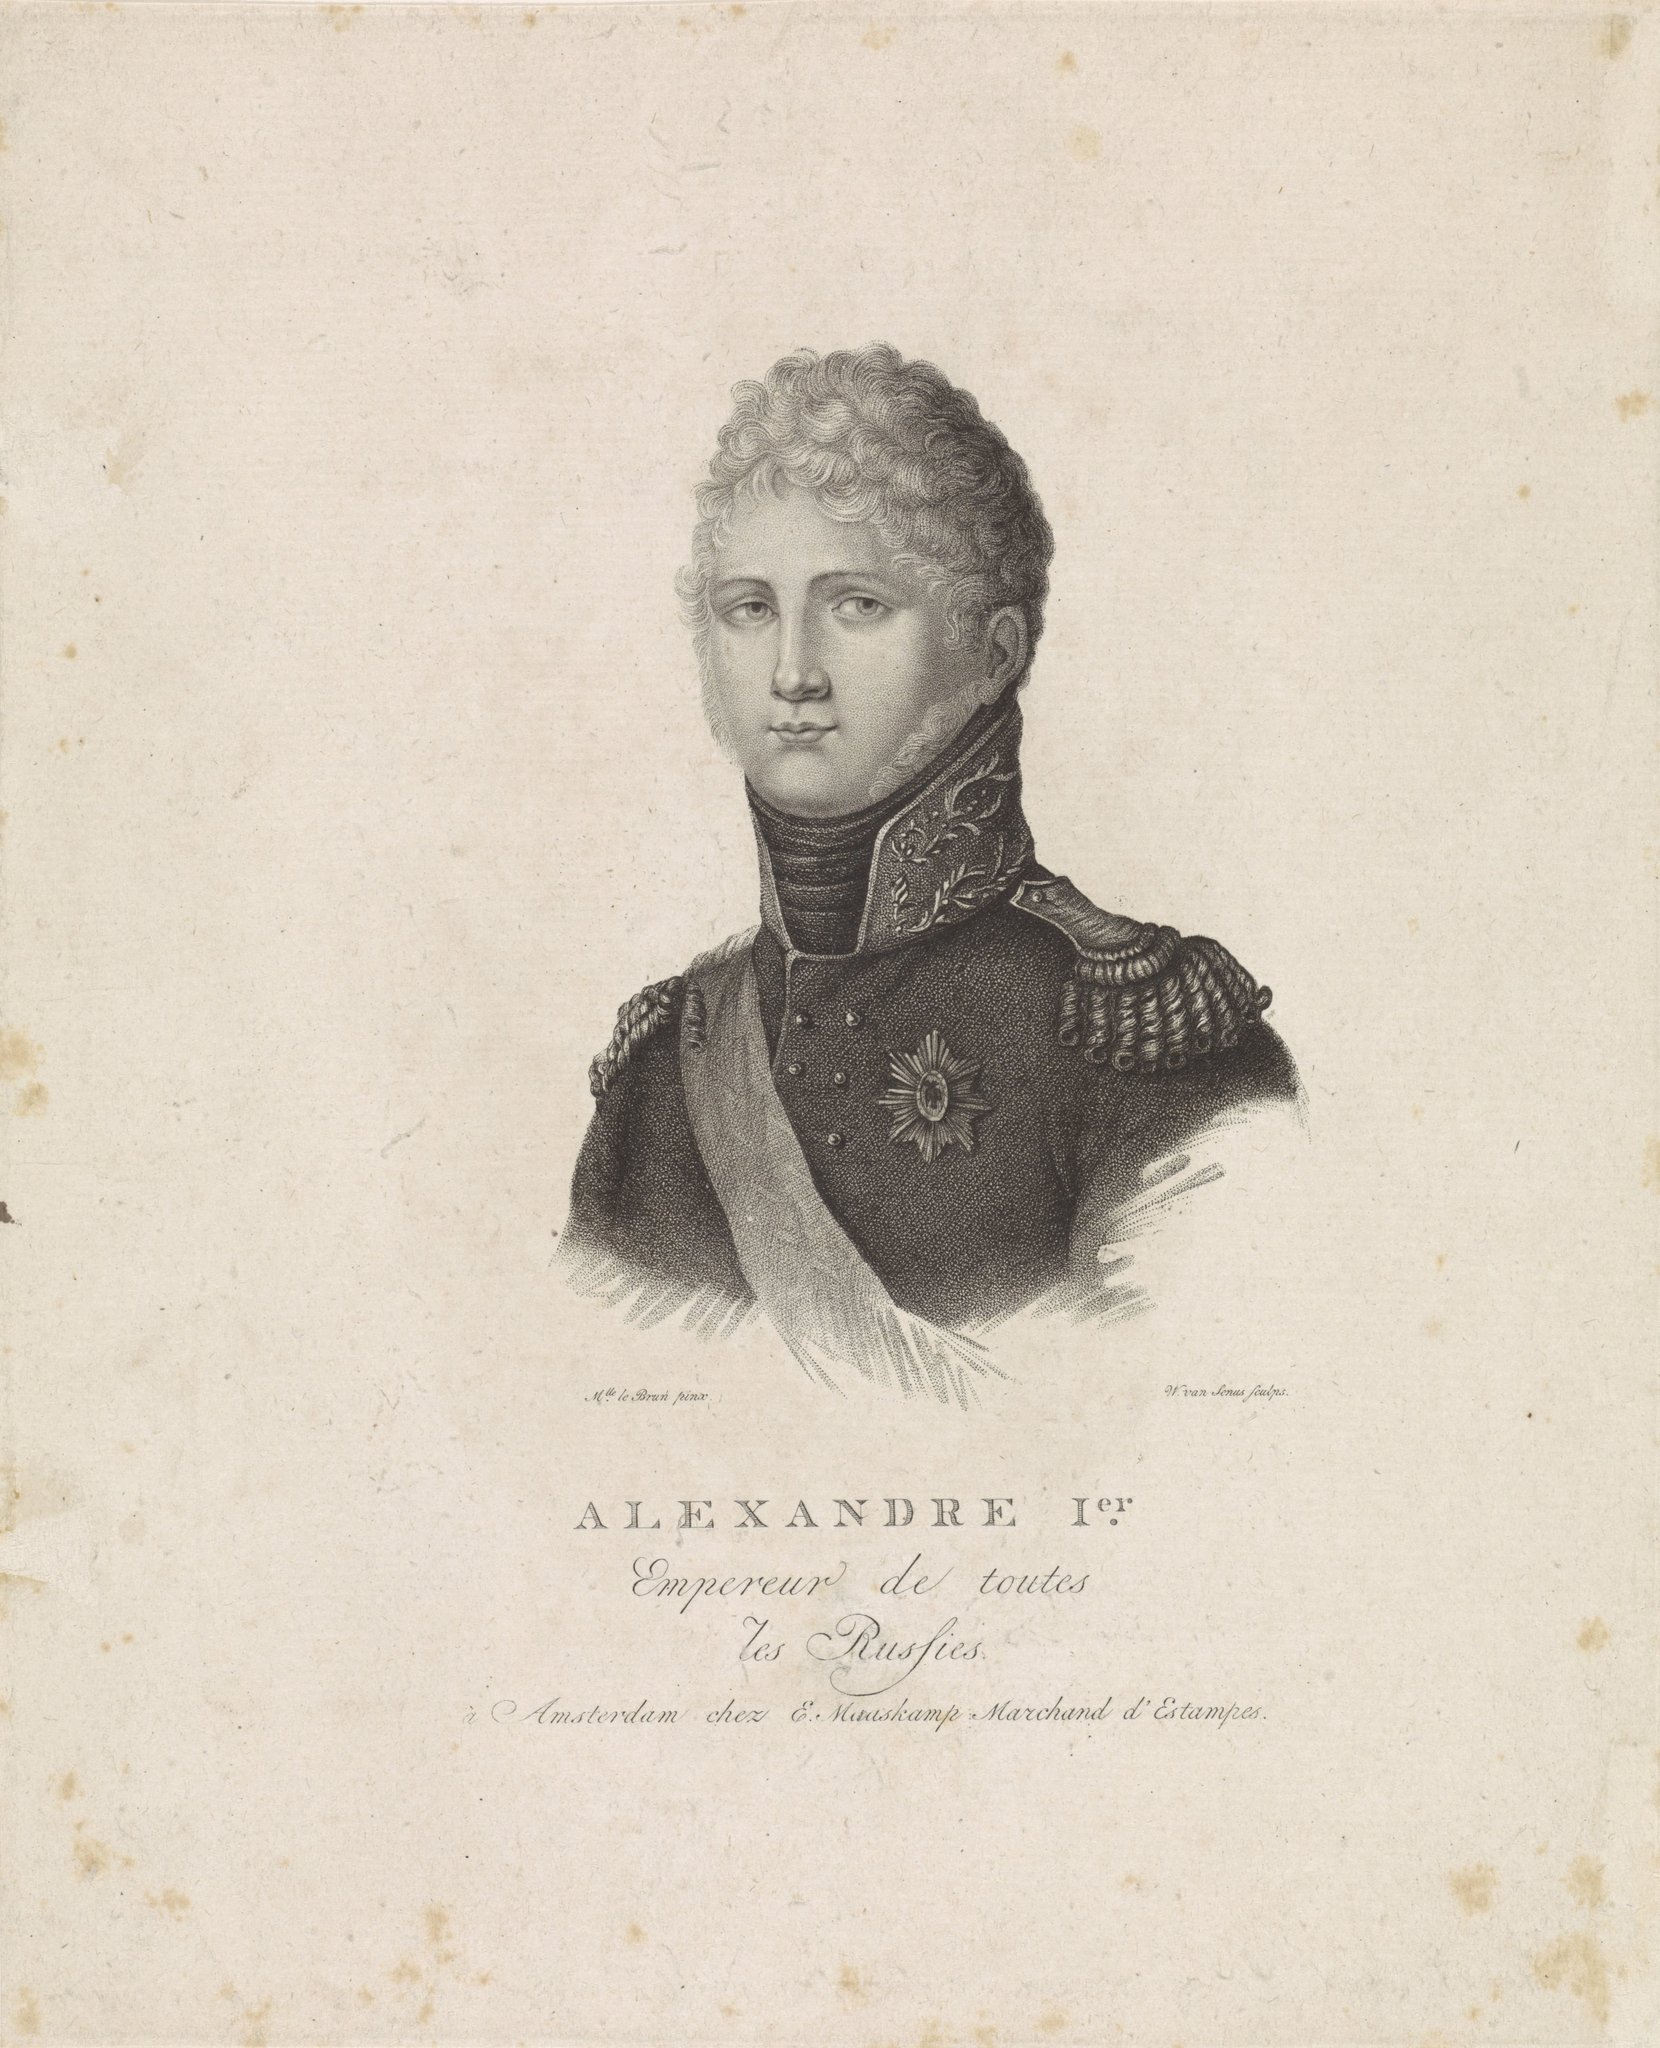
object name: print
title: Portret van Alexander I (tsaar van Rusland)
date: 1801-1834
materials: paper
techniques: engraving, etching, roulette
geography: amsterdam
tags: alexander i (tsaar van rusland)